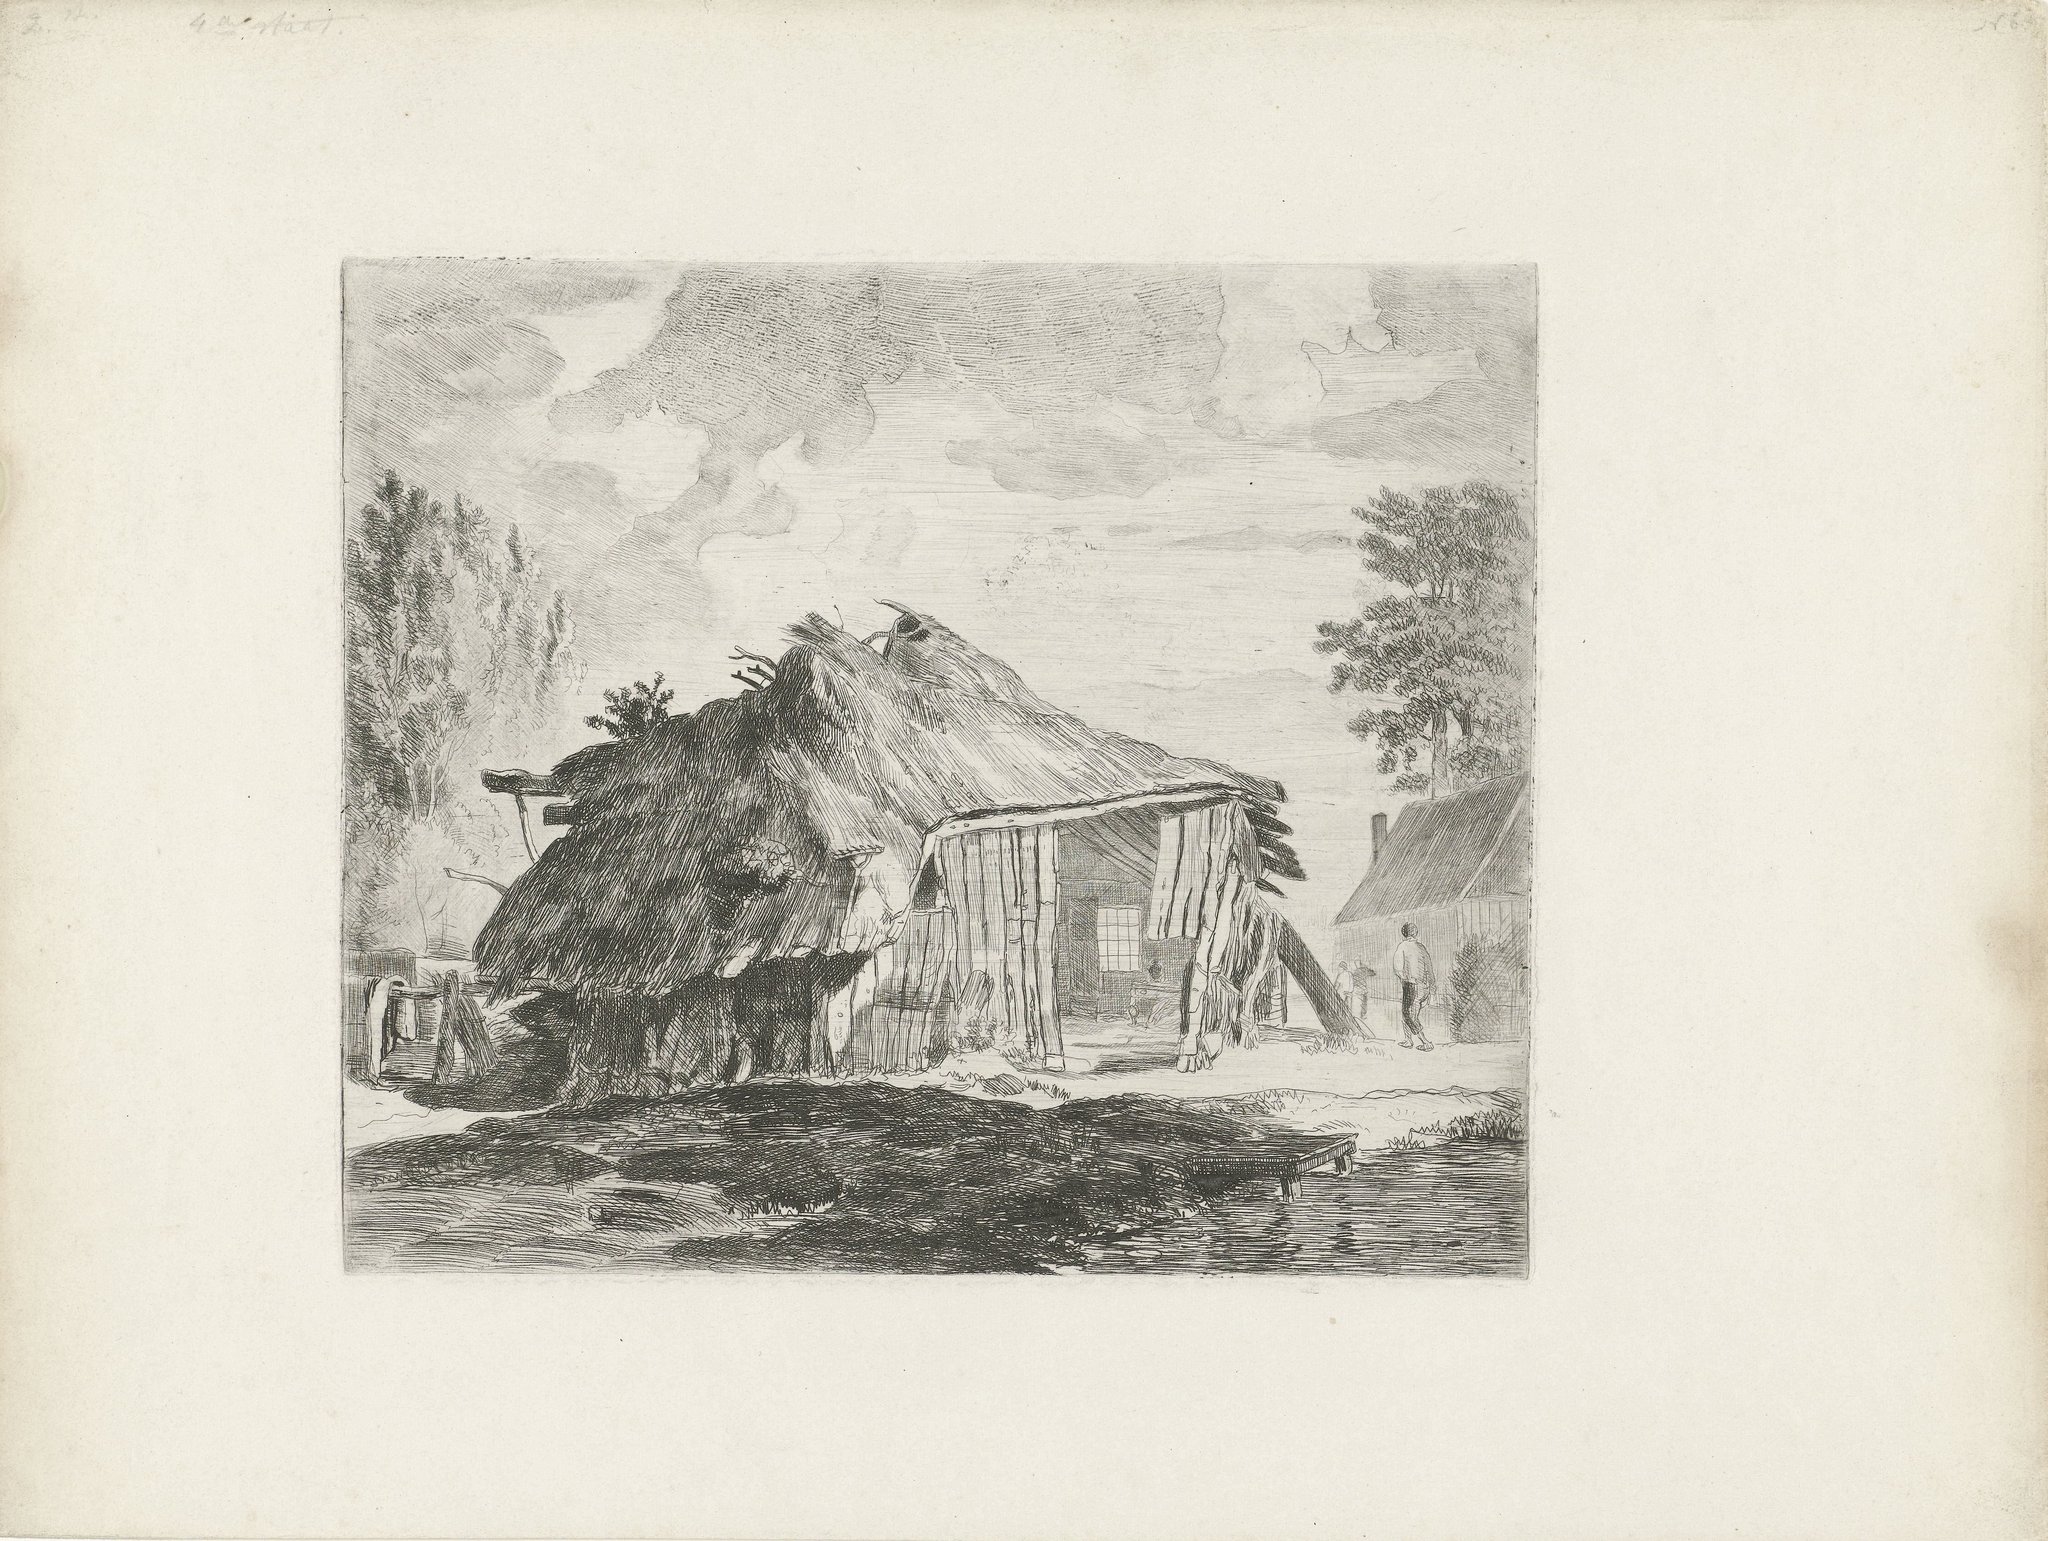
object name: print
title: Brabantsche schuur te Kaatsheuvel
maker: cornelis van der griendt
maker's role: draughtsman, painter, print maker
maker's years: 1827-1918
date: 1858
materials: paper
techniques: drypoint, etching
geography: netherlands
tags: barn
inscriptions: collector's mark: Lugt 2228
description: Schuur in een landschap aan water gelegen. Aan de rechterzijde drie figuren.